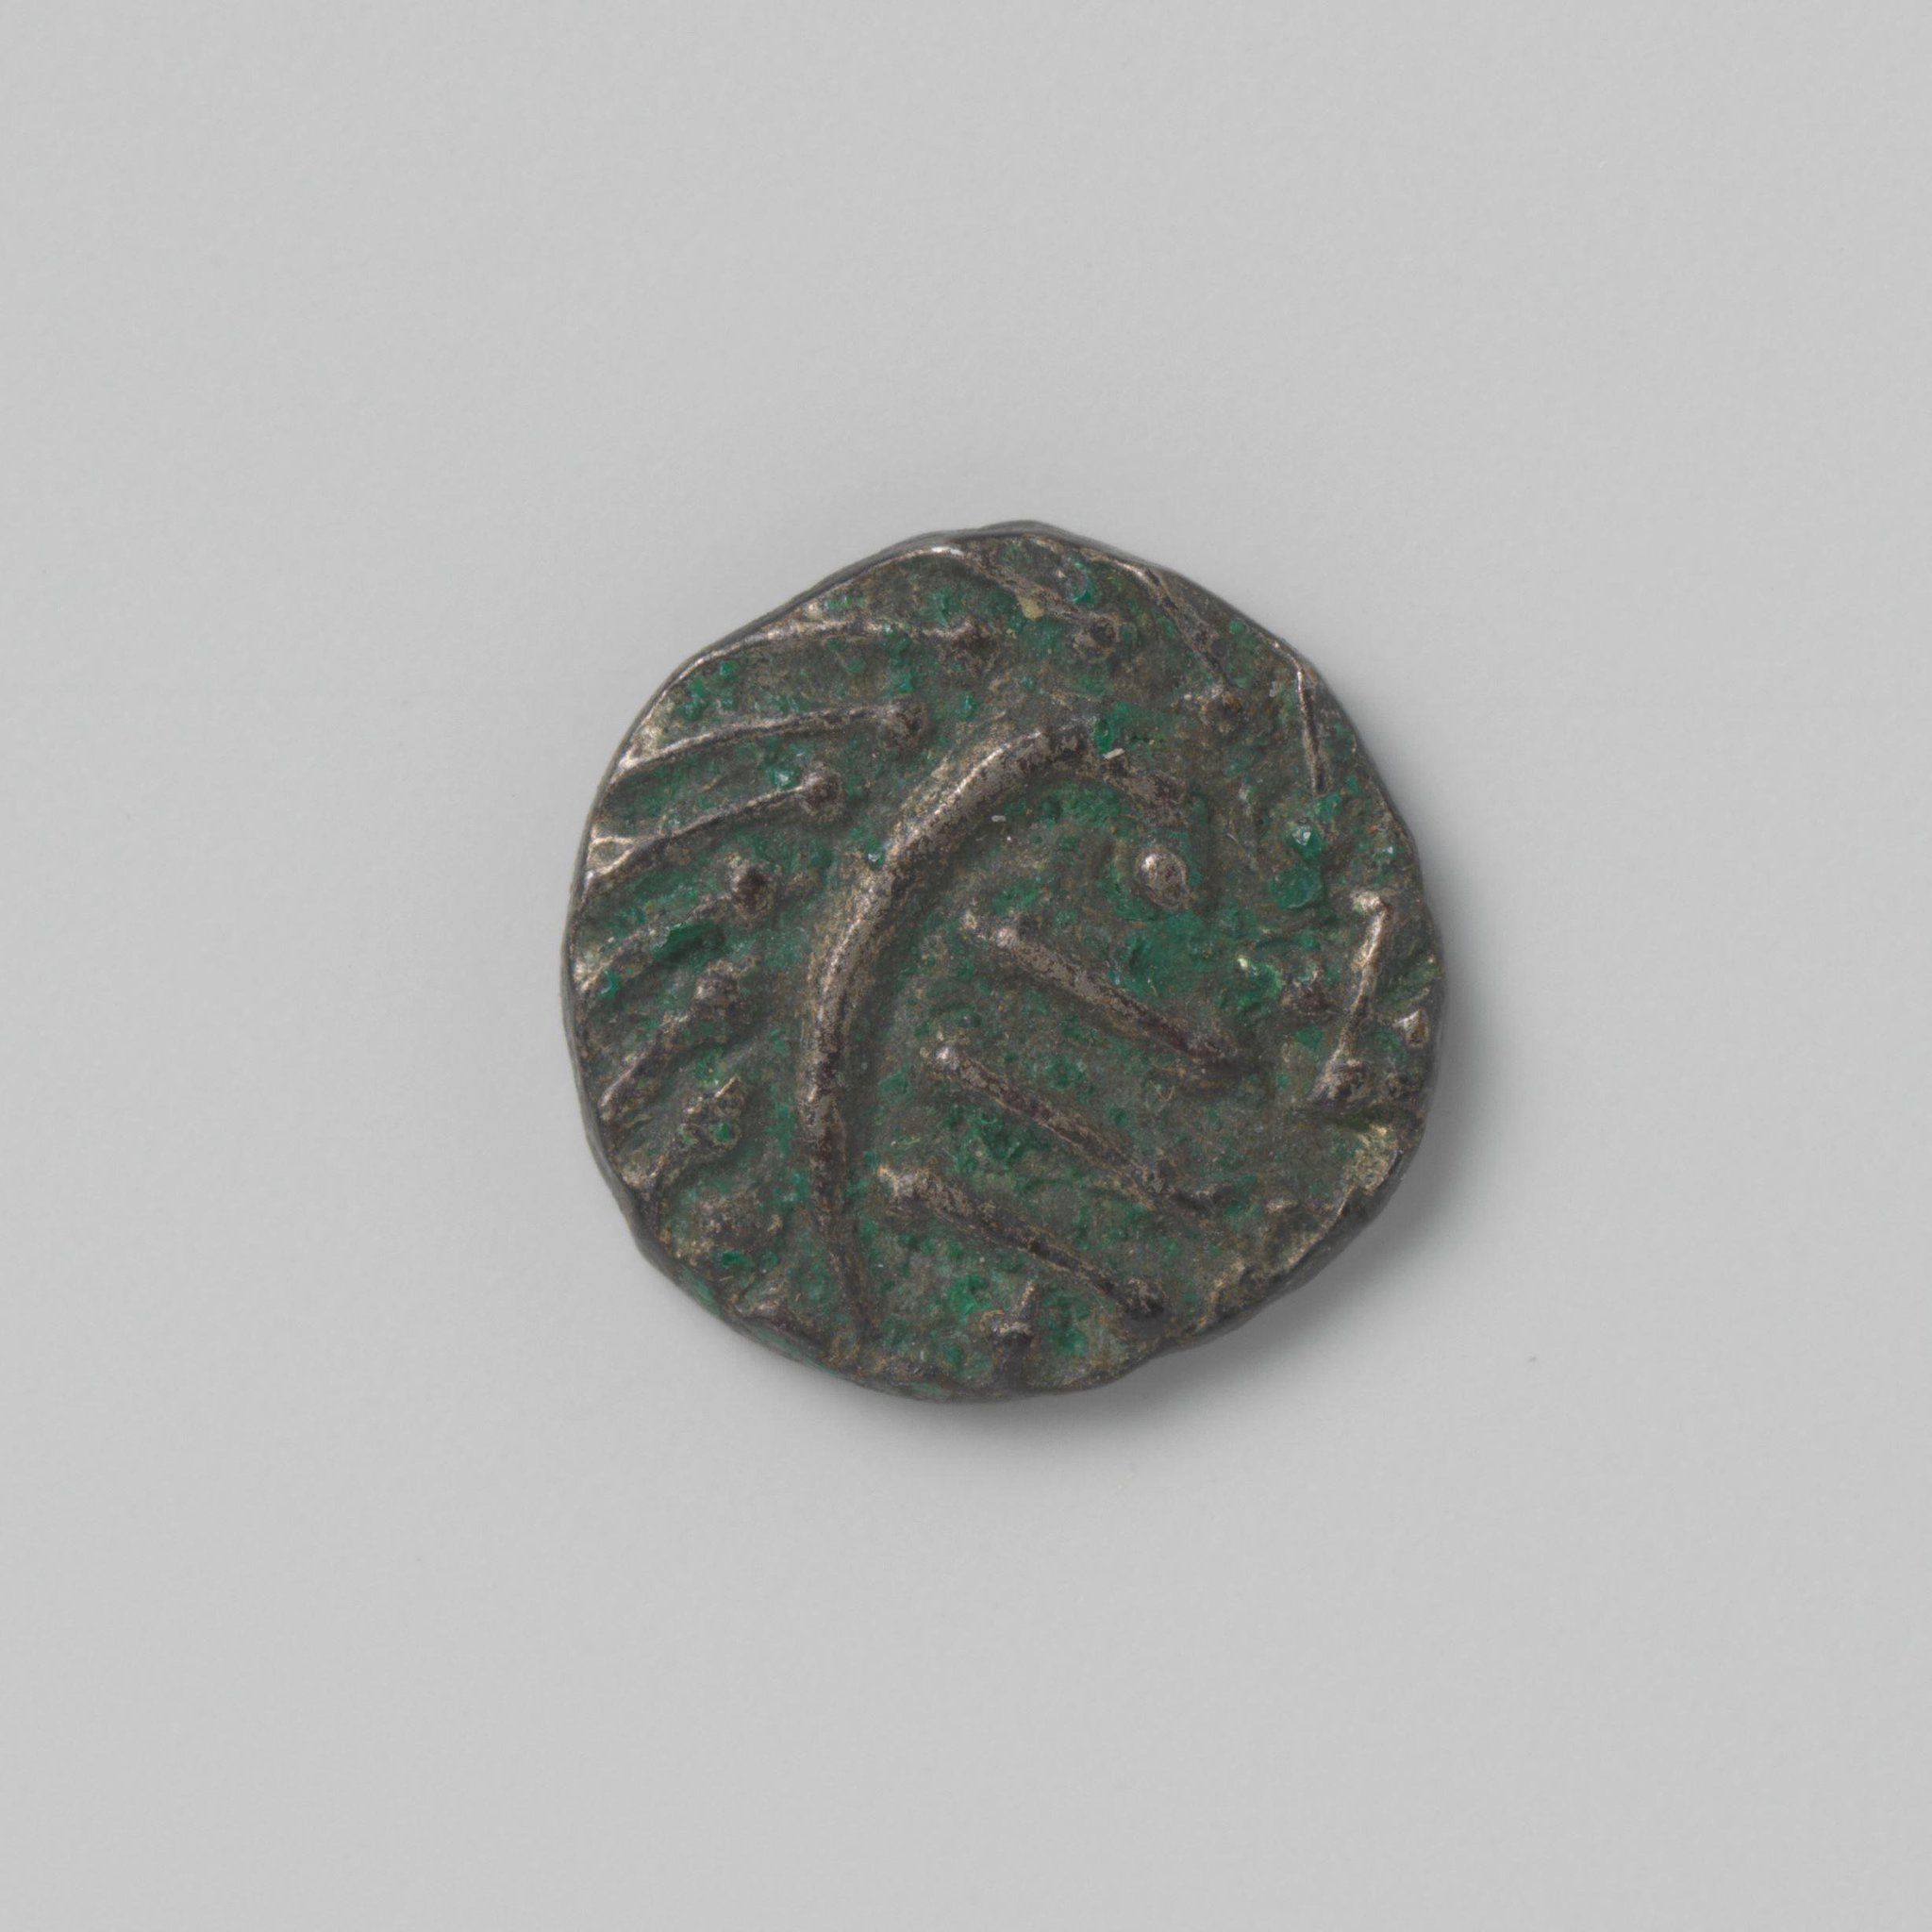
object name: coin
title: Friese sceatta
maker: Anonymous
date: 601-699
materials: silver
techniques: striking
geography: friesland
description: Zilveren munt. Voorzijde: zogenaamde stekelvarken. Keerzijde: zogenaamde standaard: vierkant, waarin onleesbare letters. rondom vierkant eveneens onleesbare letters.